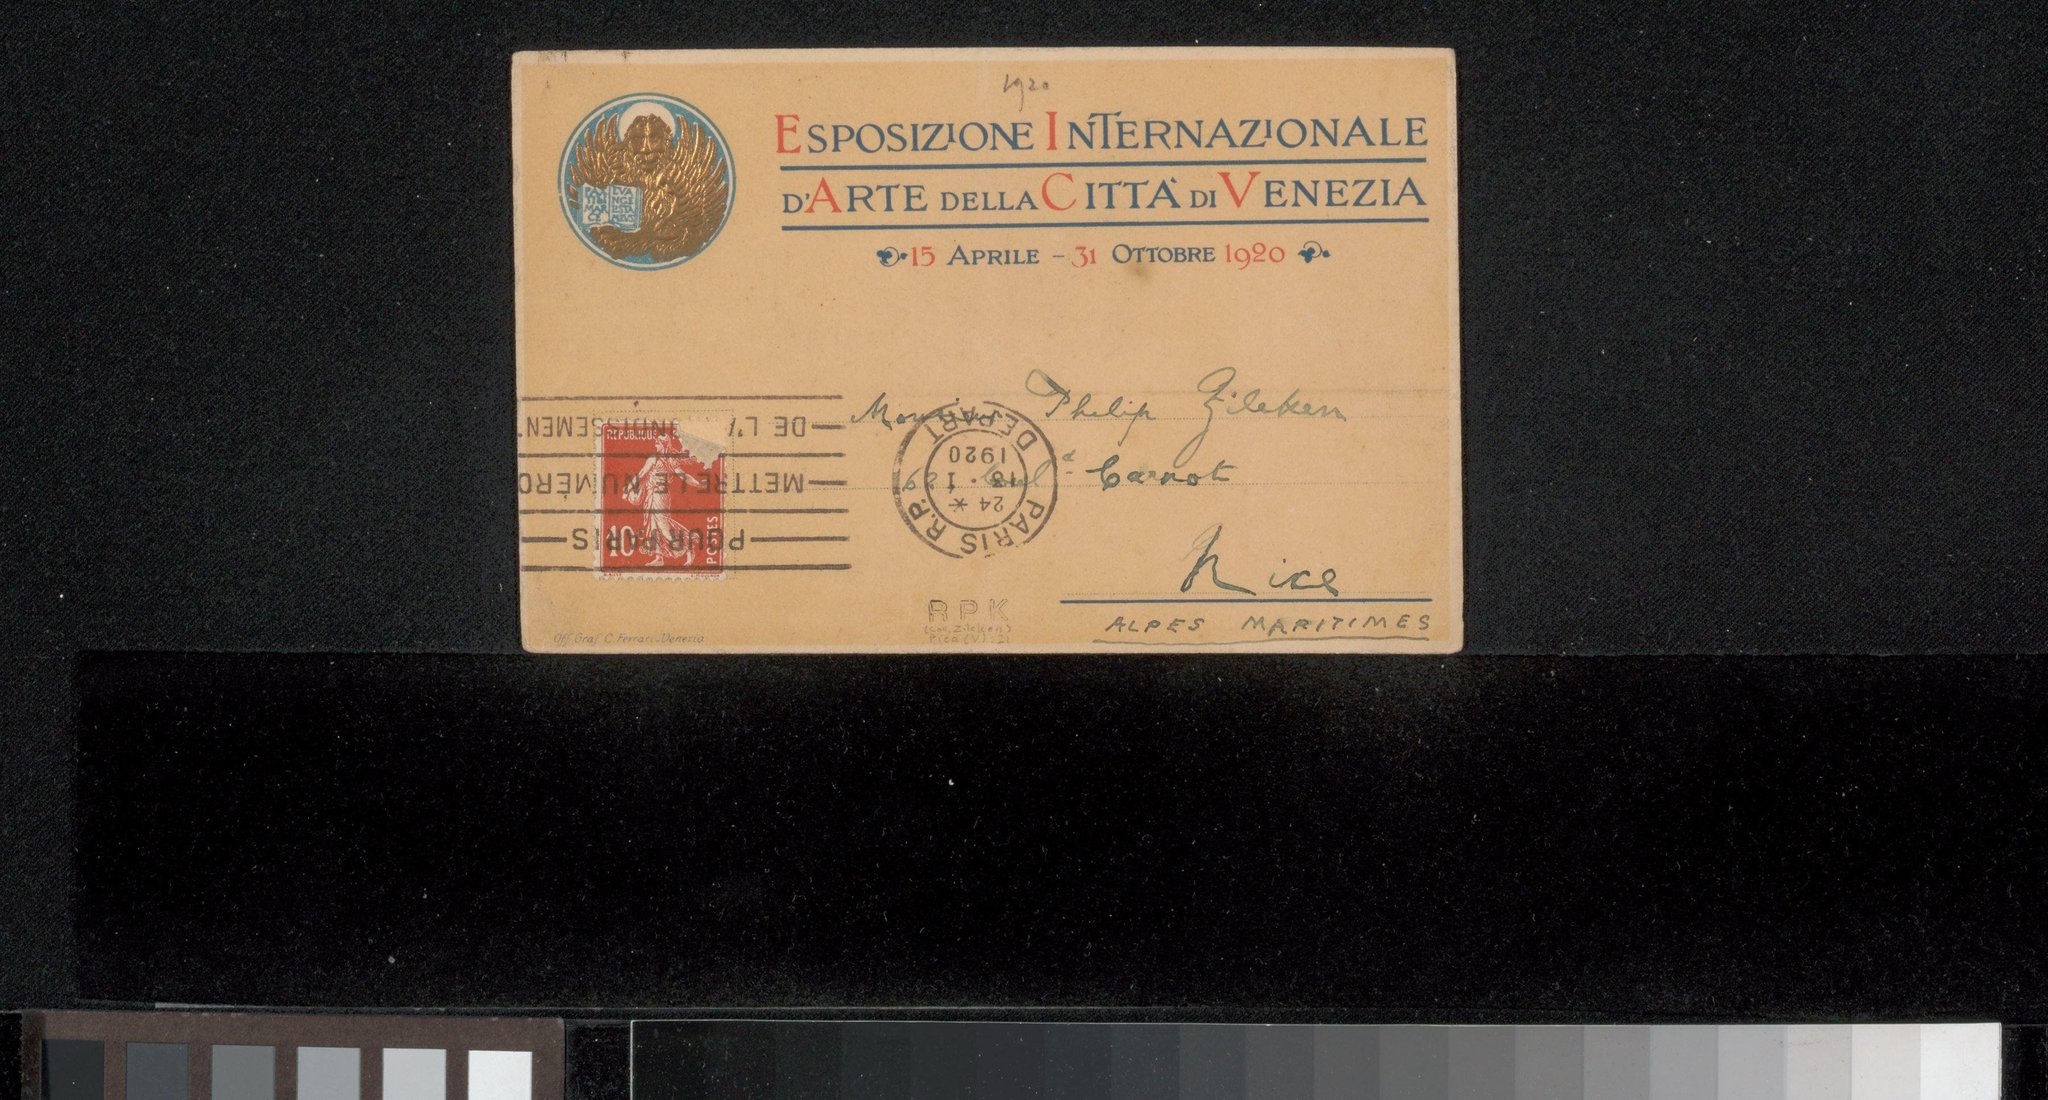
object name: postcard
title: Briefkaart aan Philip Zilcken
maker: vittorio pica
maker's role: criticus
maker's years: 1864-1930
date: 1920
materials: cardboard, ink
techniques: pen, writing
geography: paris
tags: vincent van gogh, painter, draughtsman, philip zilcken, printed matter, paris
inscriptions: collector's mark: ‘RPK’